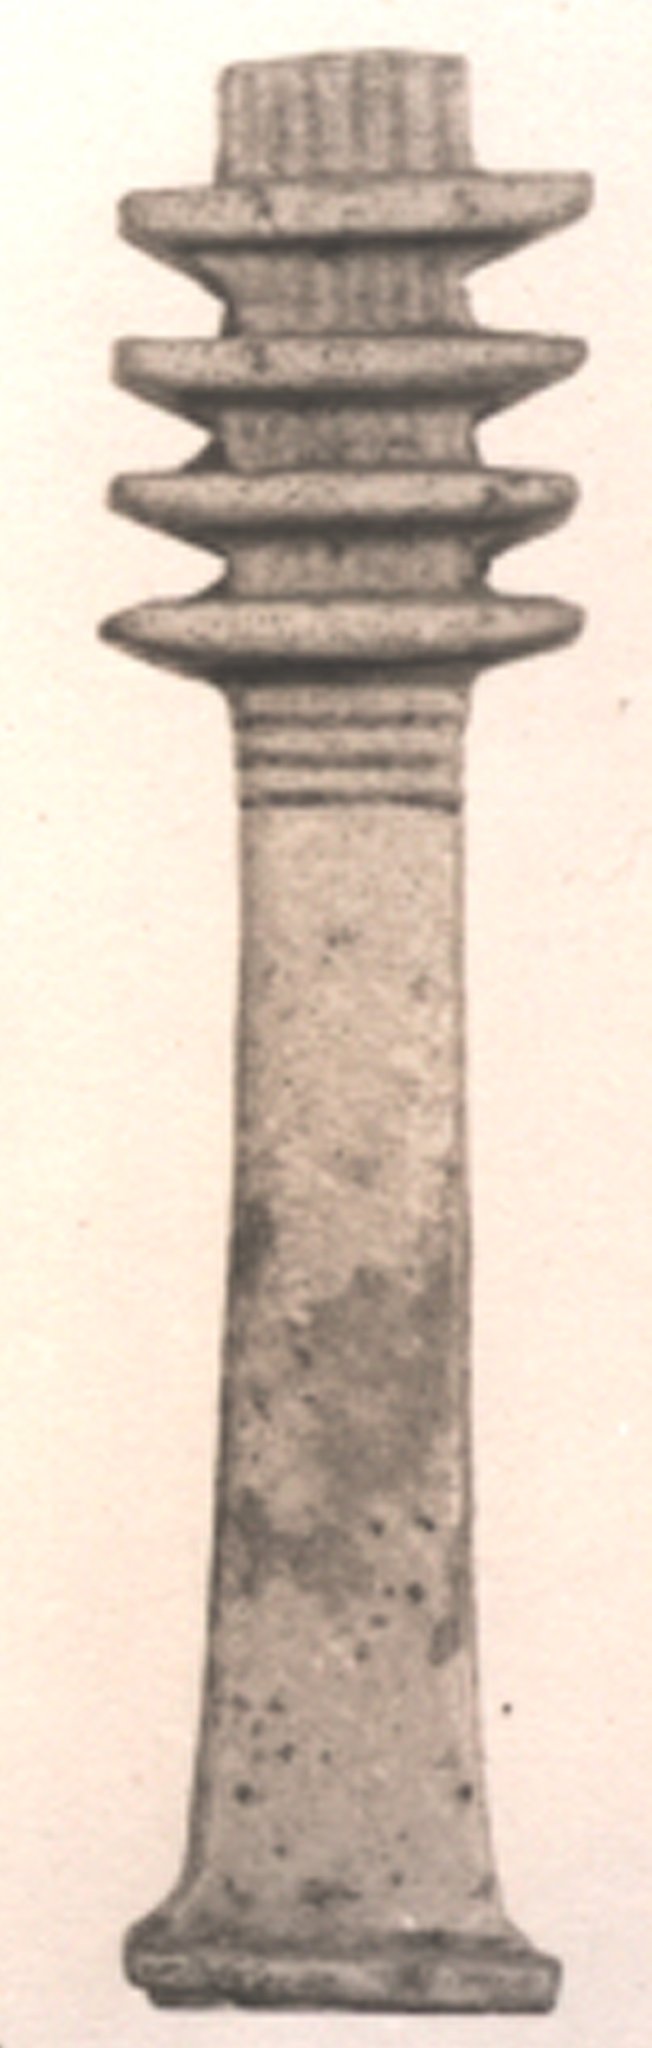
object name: amulet, djed pillar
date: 664-332 BCE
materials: faience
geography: egypt